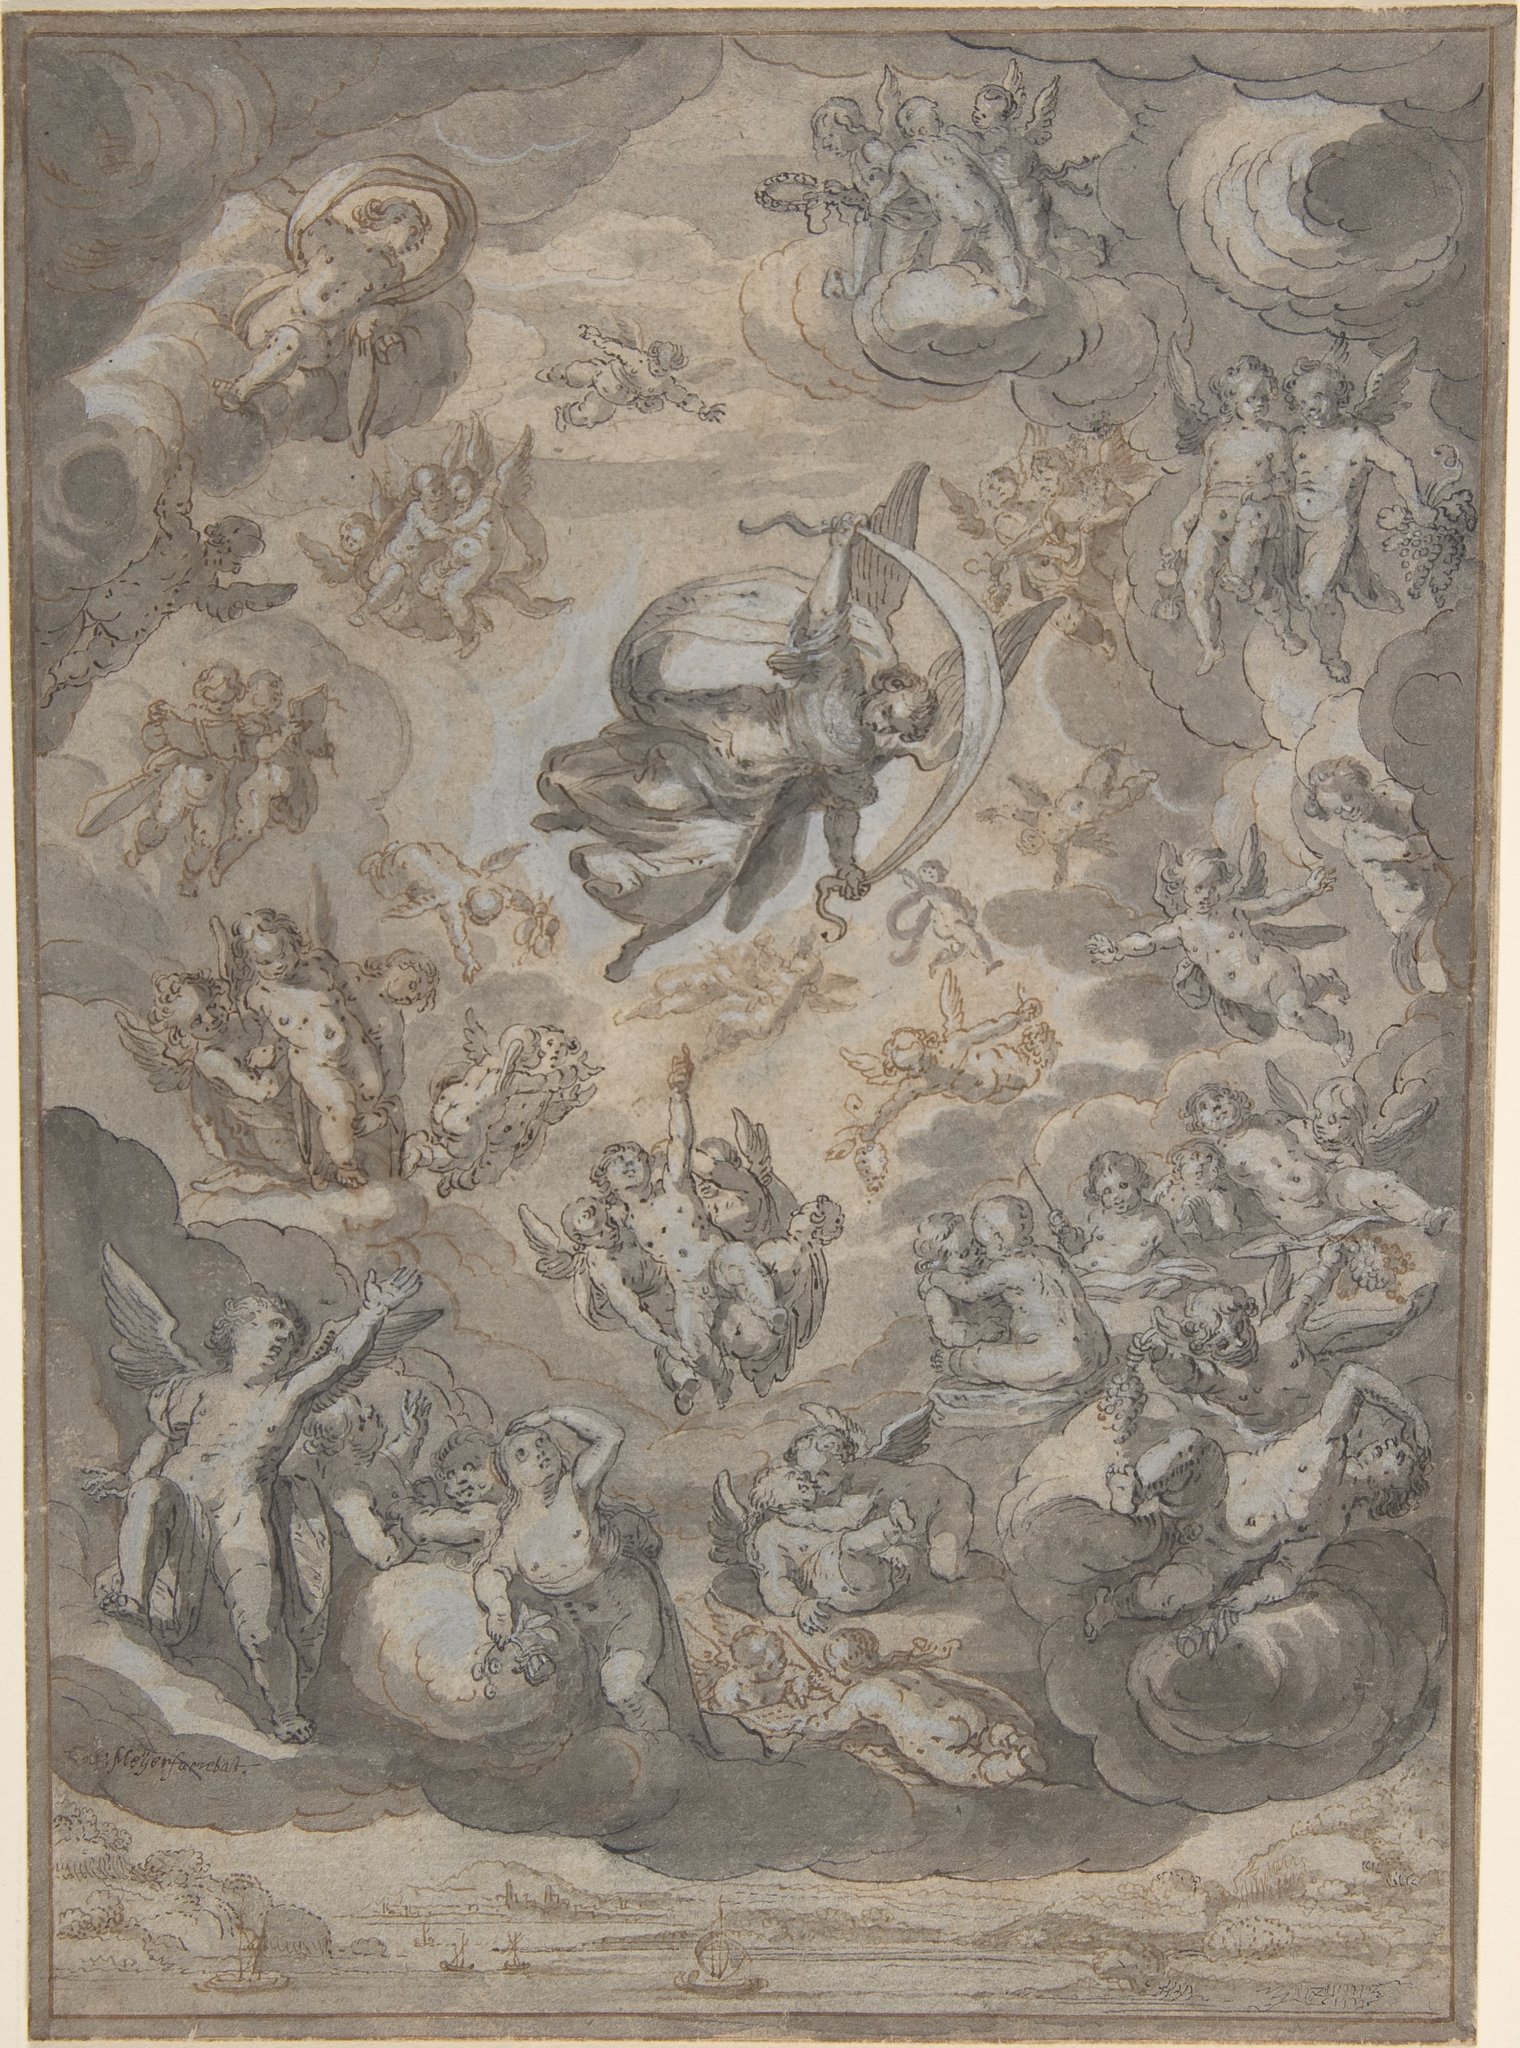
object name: drawing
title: Flying Putti, Surrounding Archangel Raphael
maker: conrad meyer (i)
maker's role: artist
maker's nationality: swiss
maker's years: 1618-1689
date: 1631-1632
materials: ink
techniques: brush, heightening, pen, wash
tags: putti,angels